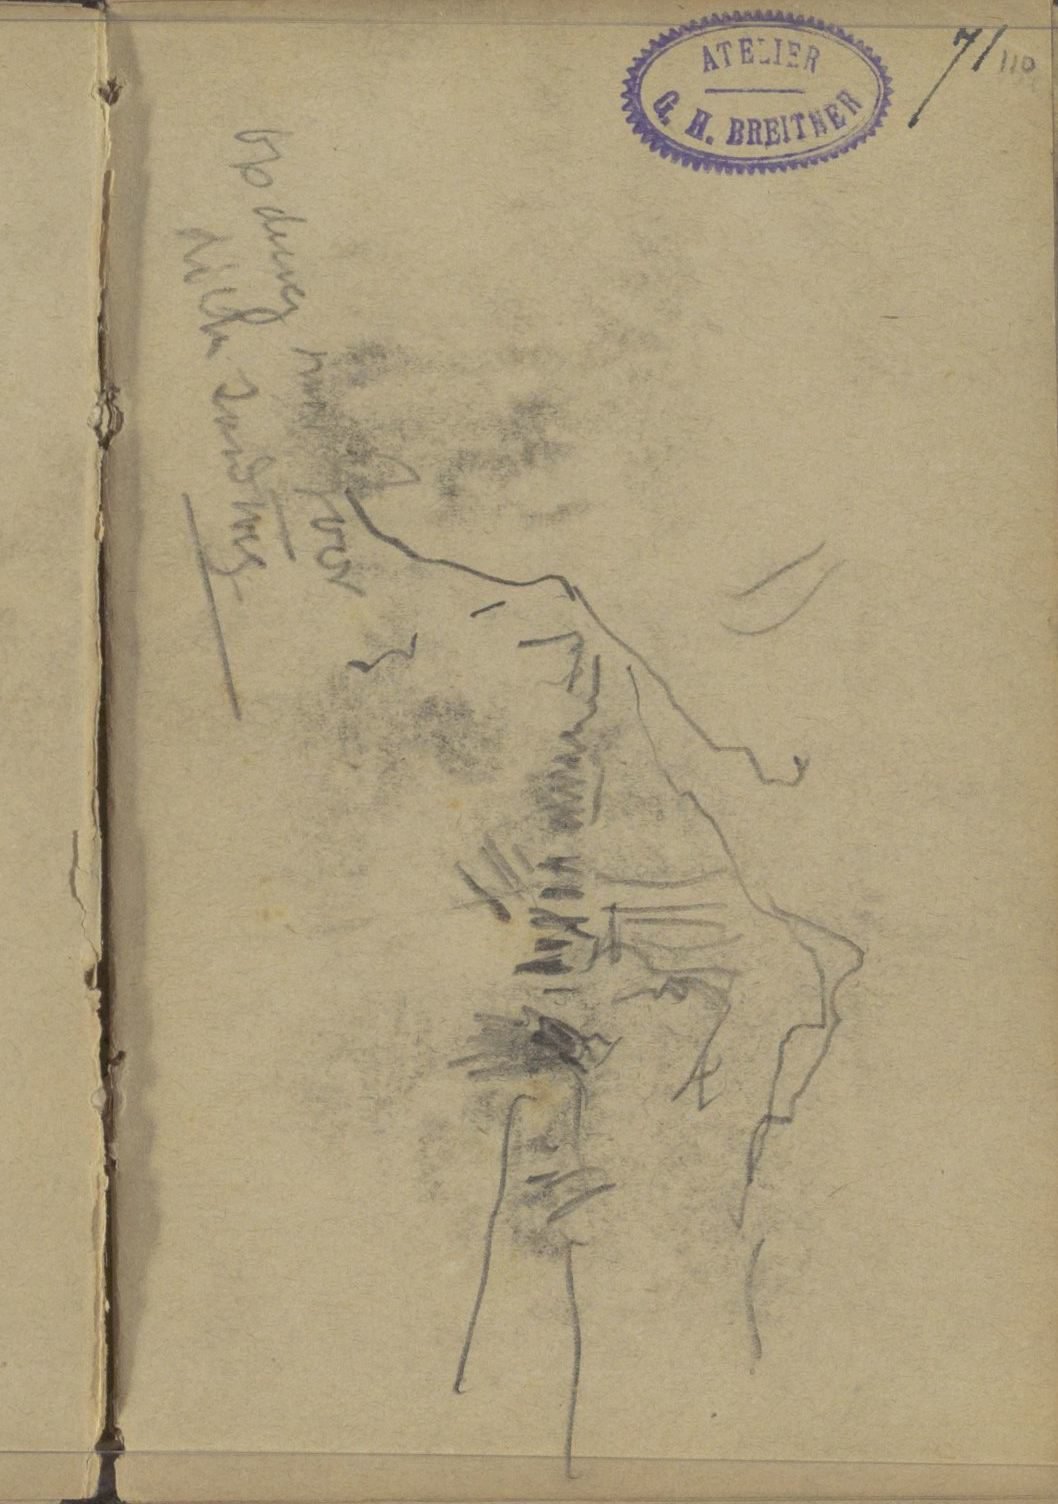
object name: sketchbook leaf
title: Figuur op een landweg nabij Goor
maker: george hendrik breitner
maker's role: draughtsman, painter, print maker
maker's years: 1857-1923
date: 1887-1891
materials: paper, pencil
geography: overijssel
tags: road, path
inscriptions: workshop stamp: Lugt 291d, annotation: ‘Op de weg naar Goor/ [...] zandweg’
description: Pagina 110 uit een schetsboek met 83 bladen.